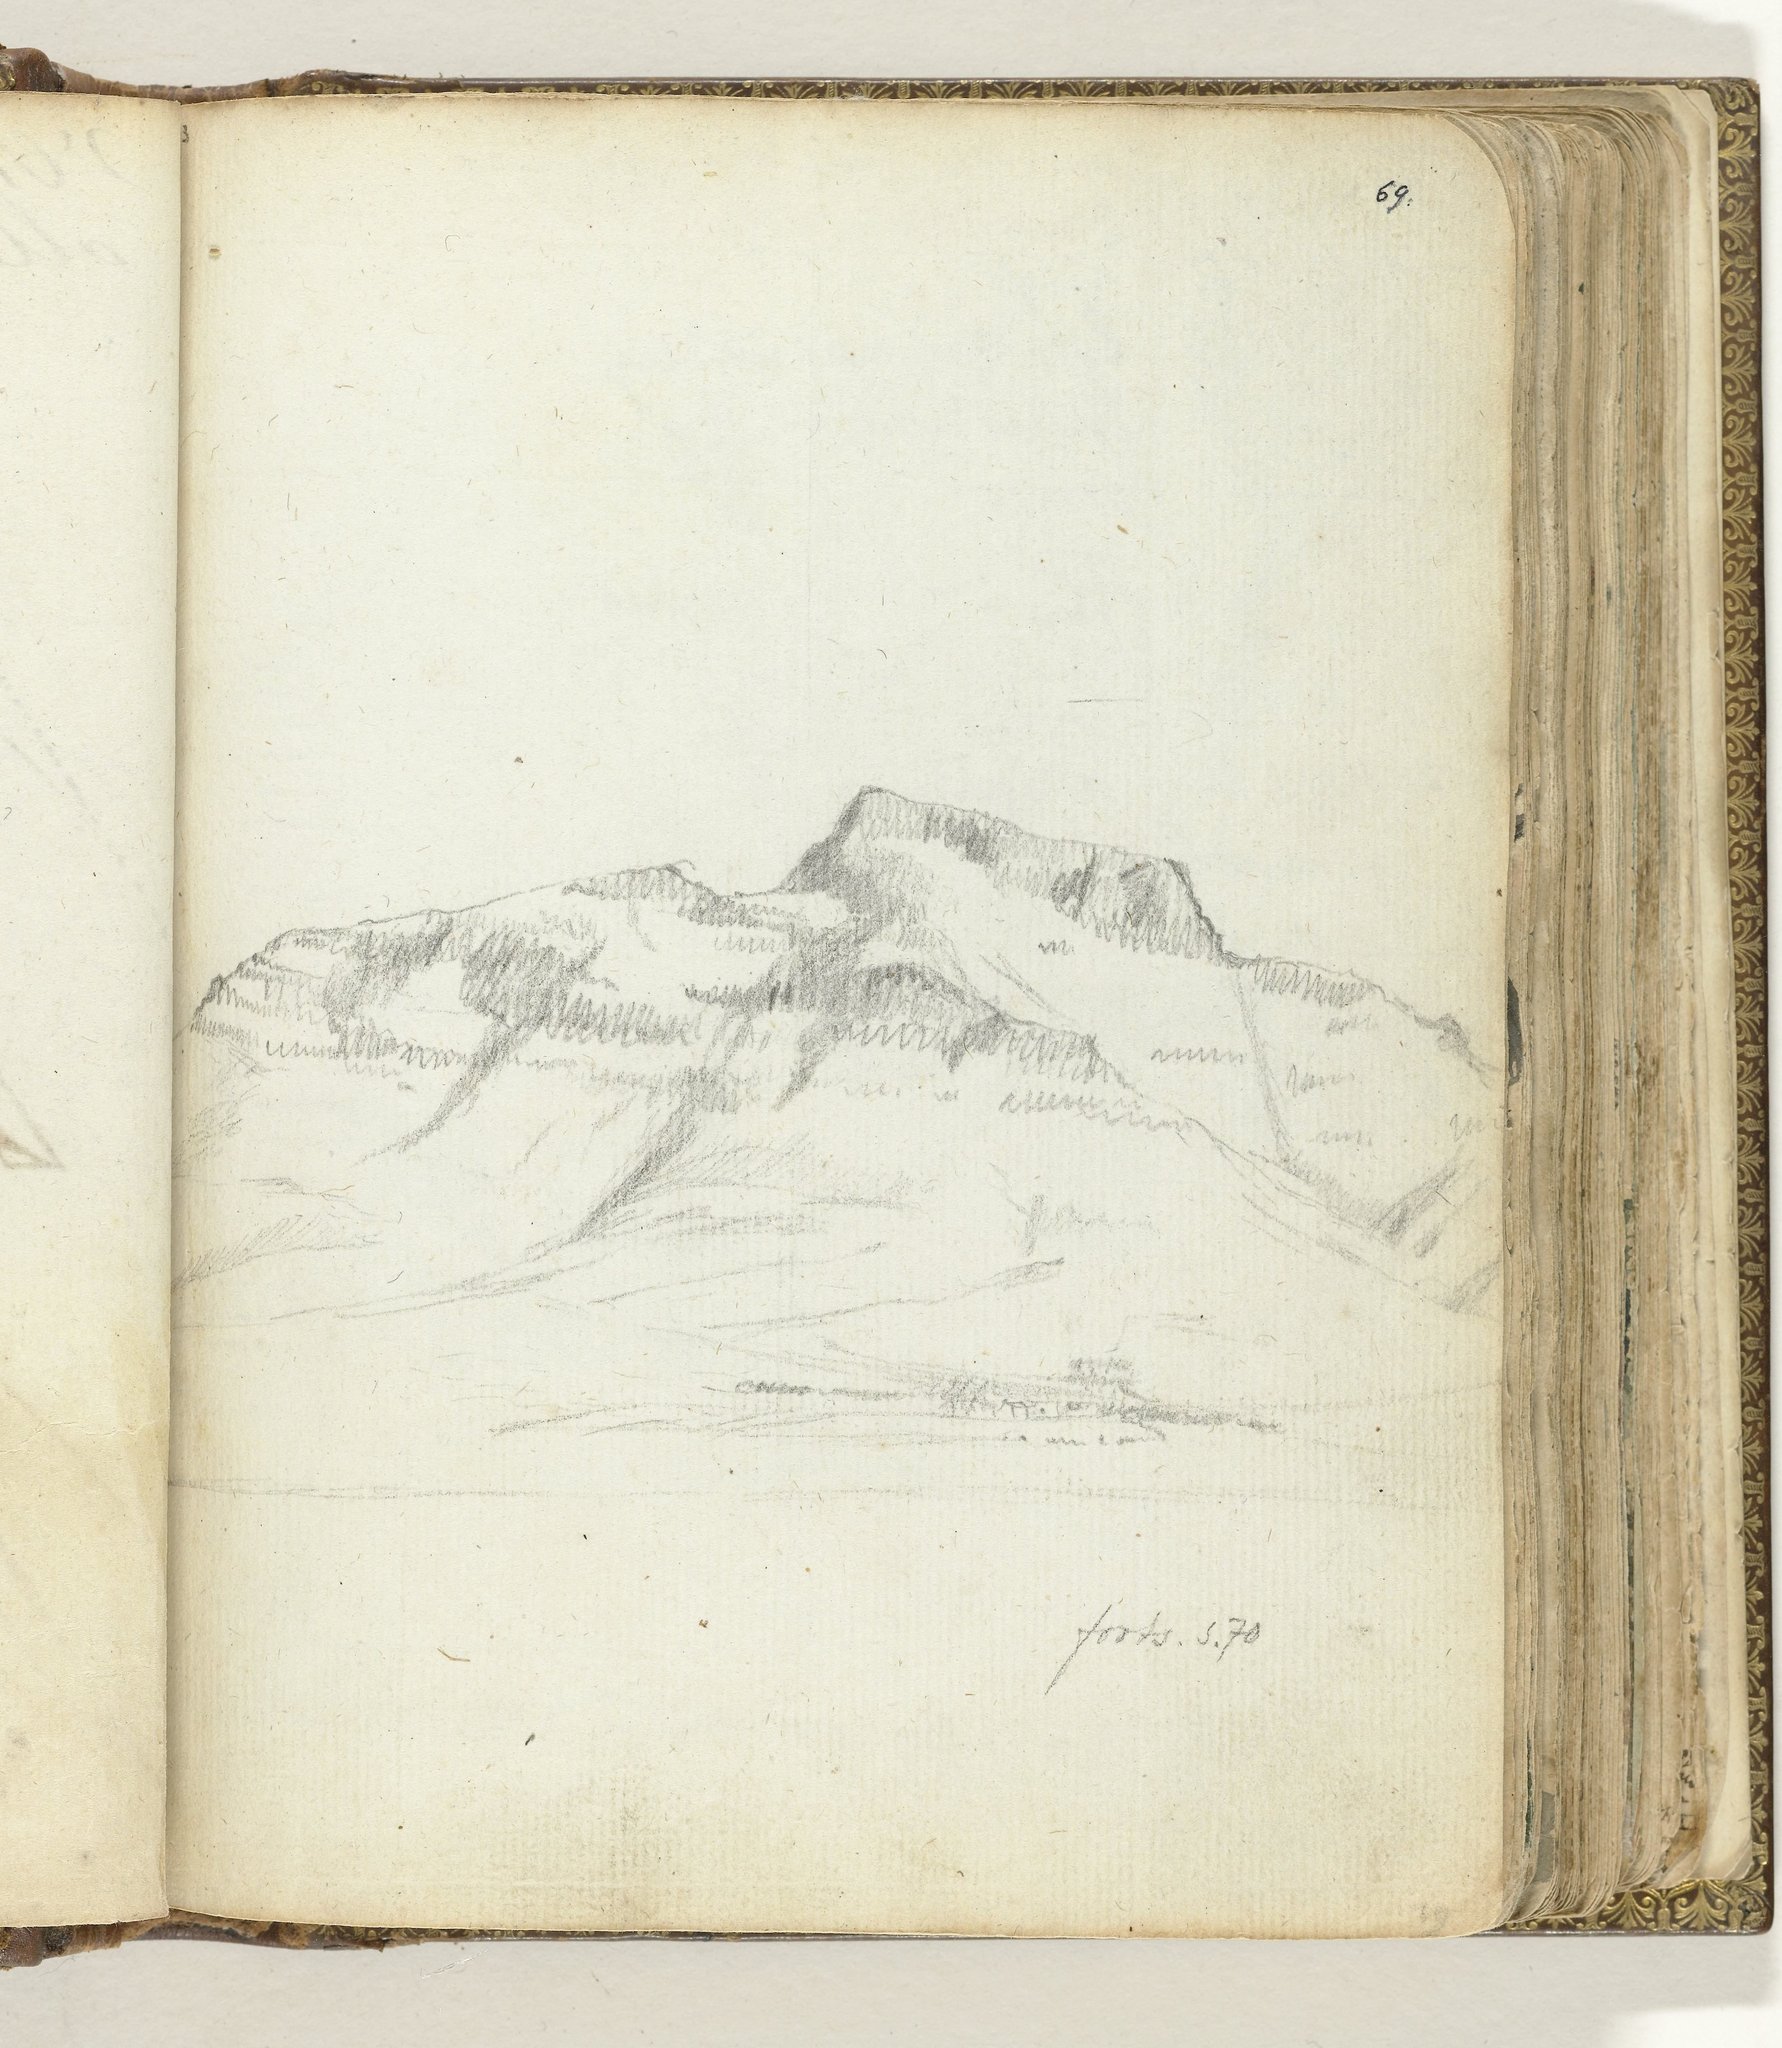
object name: drawing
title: Gezicht op Kaap de Goede Hoop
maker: jan brandes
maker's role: draughtsman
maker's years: 1743-1808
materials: paper, pencil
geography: cape town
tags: mountains, cape of good hope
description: Potloodschets over 4 pagina's van Kaap de Goede Hoop van zee gezien. Schets van een vogelnest. Schets van een struik of boom. Met opschrift. Onderdeel uit het schetsboek van Jan Brandes, dl. 1 (1808), p. 69-72.